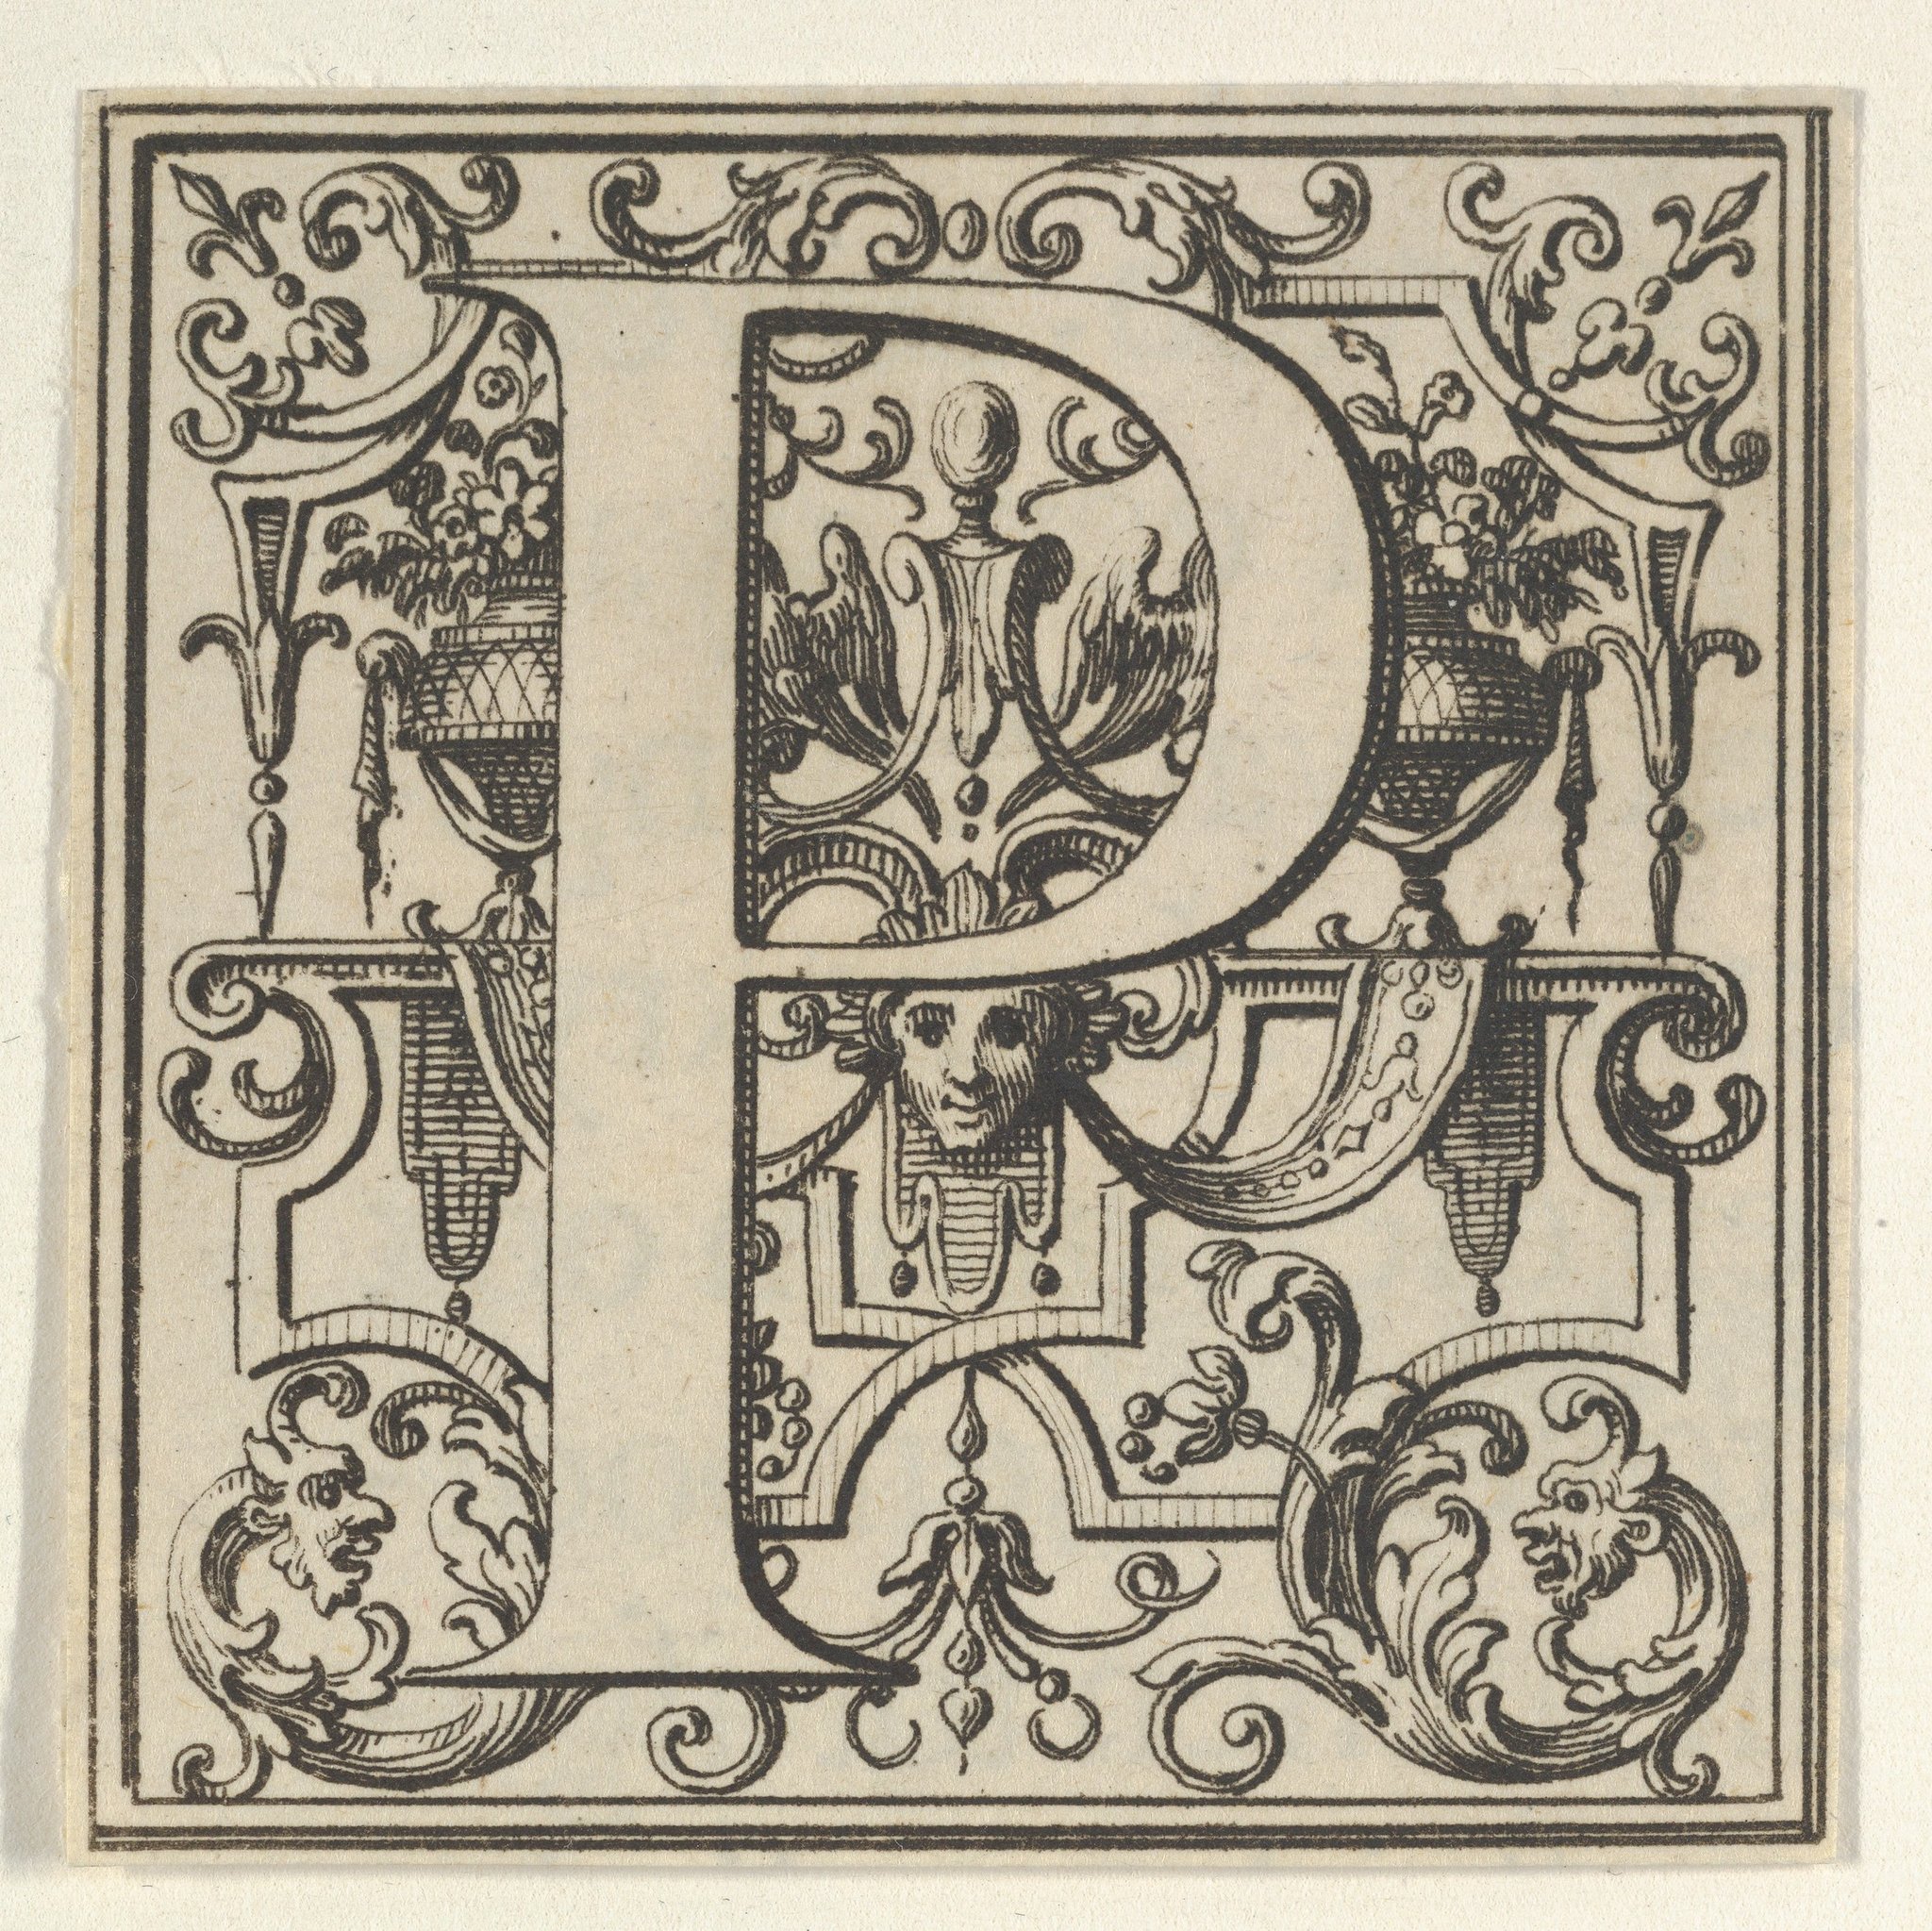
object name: print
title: Roman Alphabet letter P with Louis XIV decoration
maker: bernard picart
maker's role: artist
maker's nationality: french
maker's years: 1673-1733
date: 1701-1800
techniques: engraving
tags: faces,flowers,vases